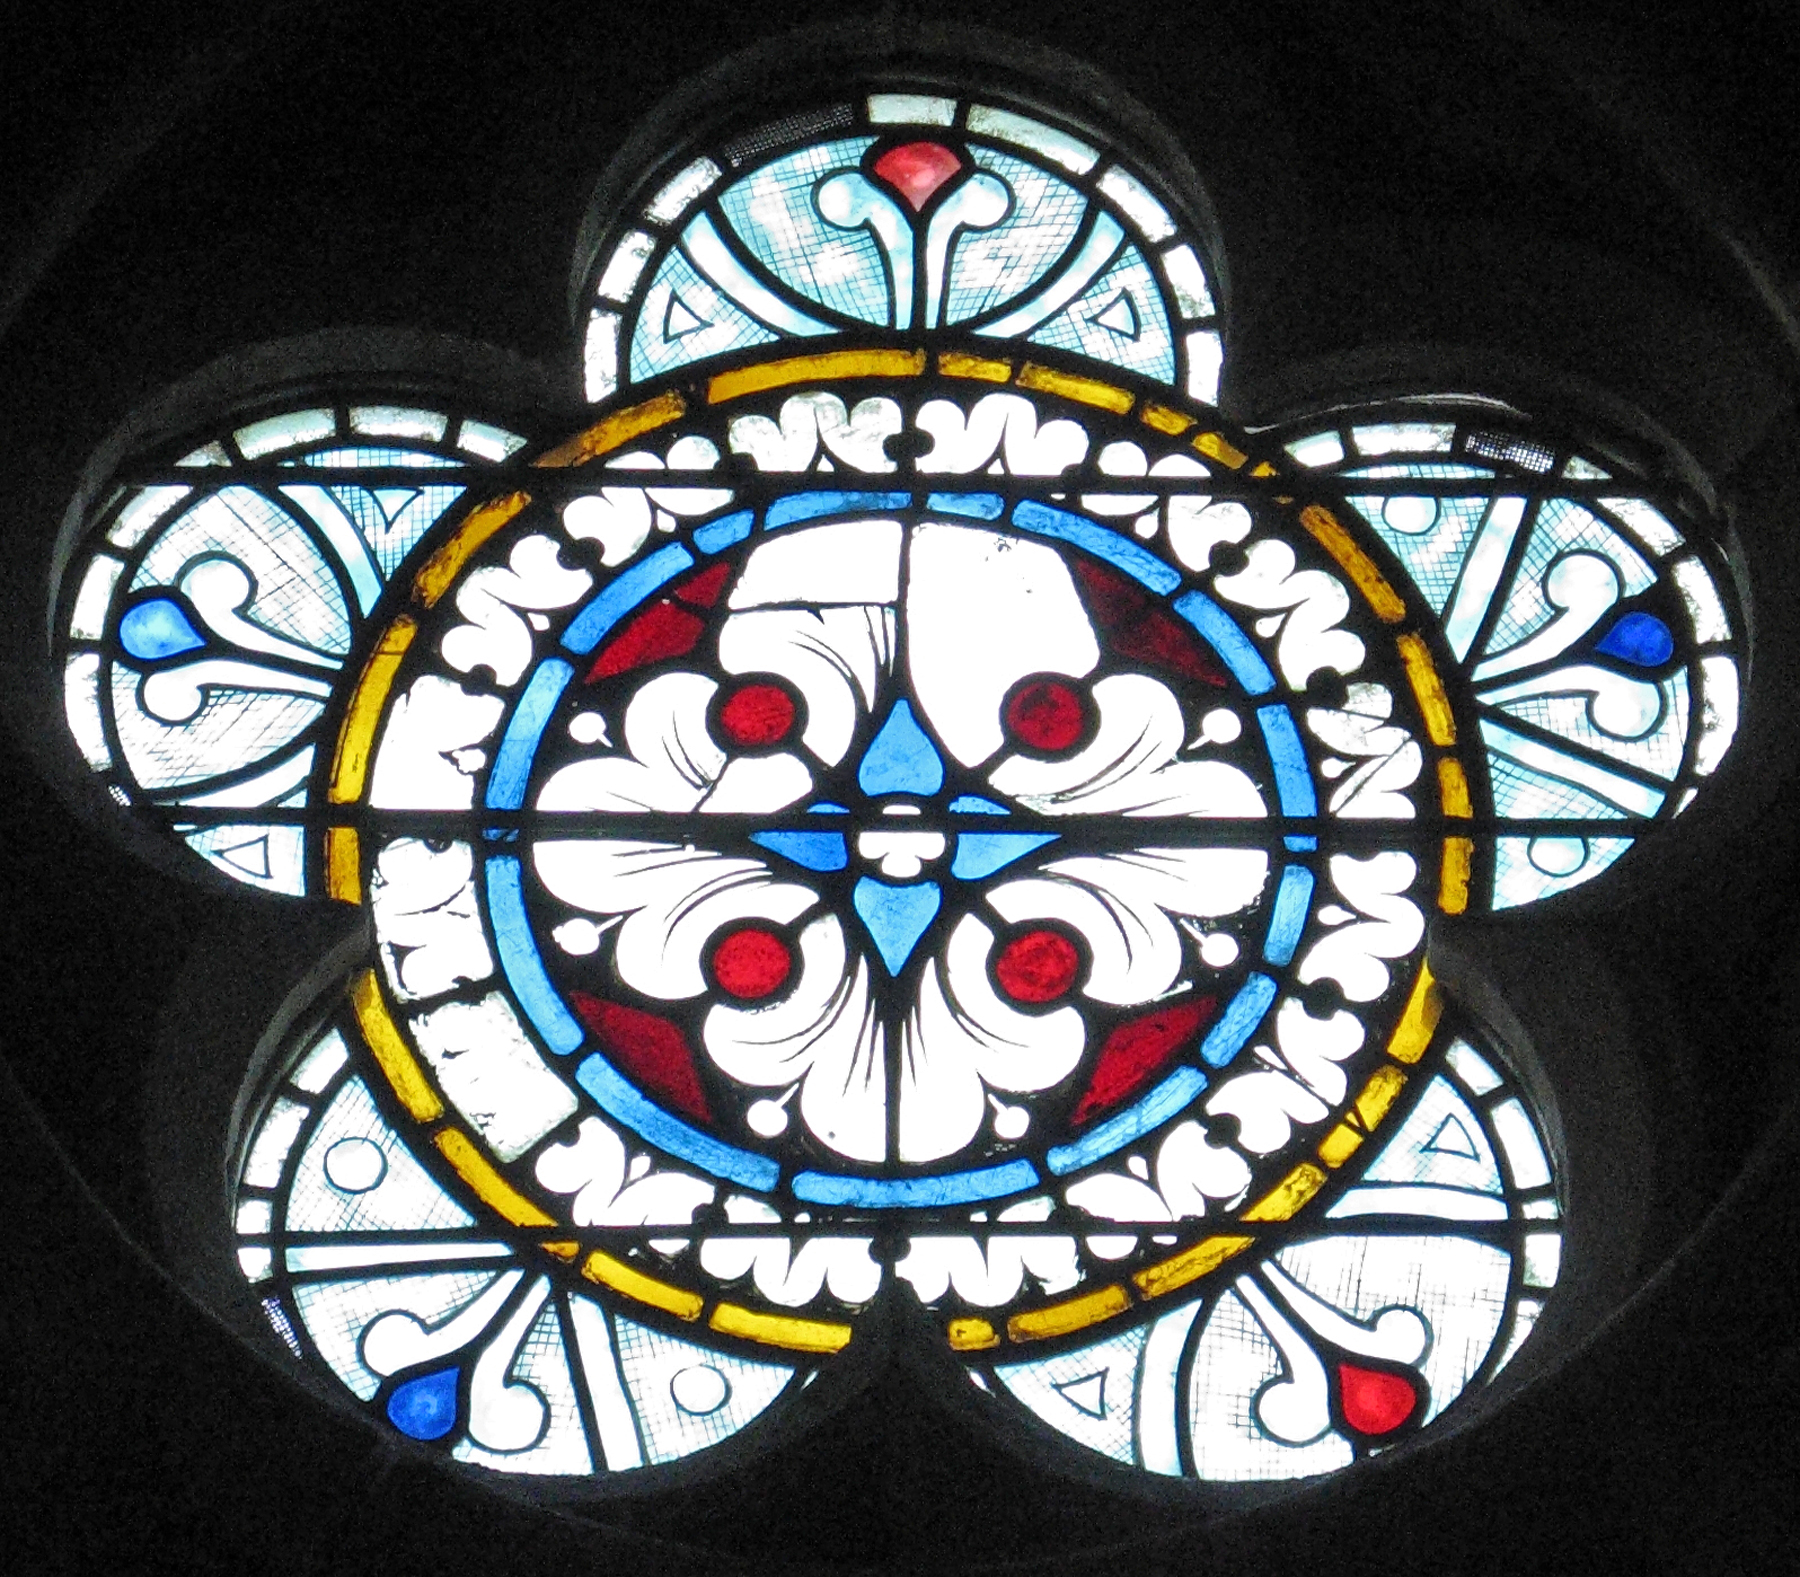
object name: roundel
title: Ornamental Roundel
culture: french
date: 1235-1240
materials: glass, metal, paint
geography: france